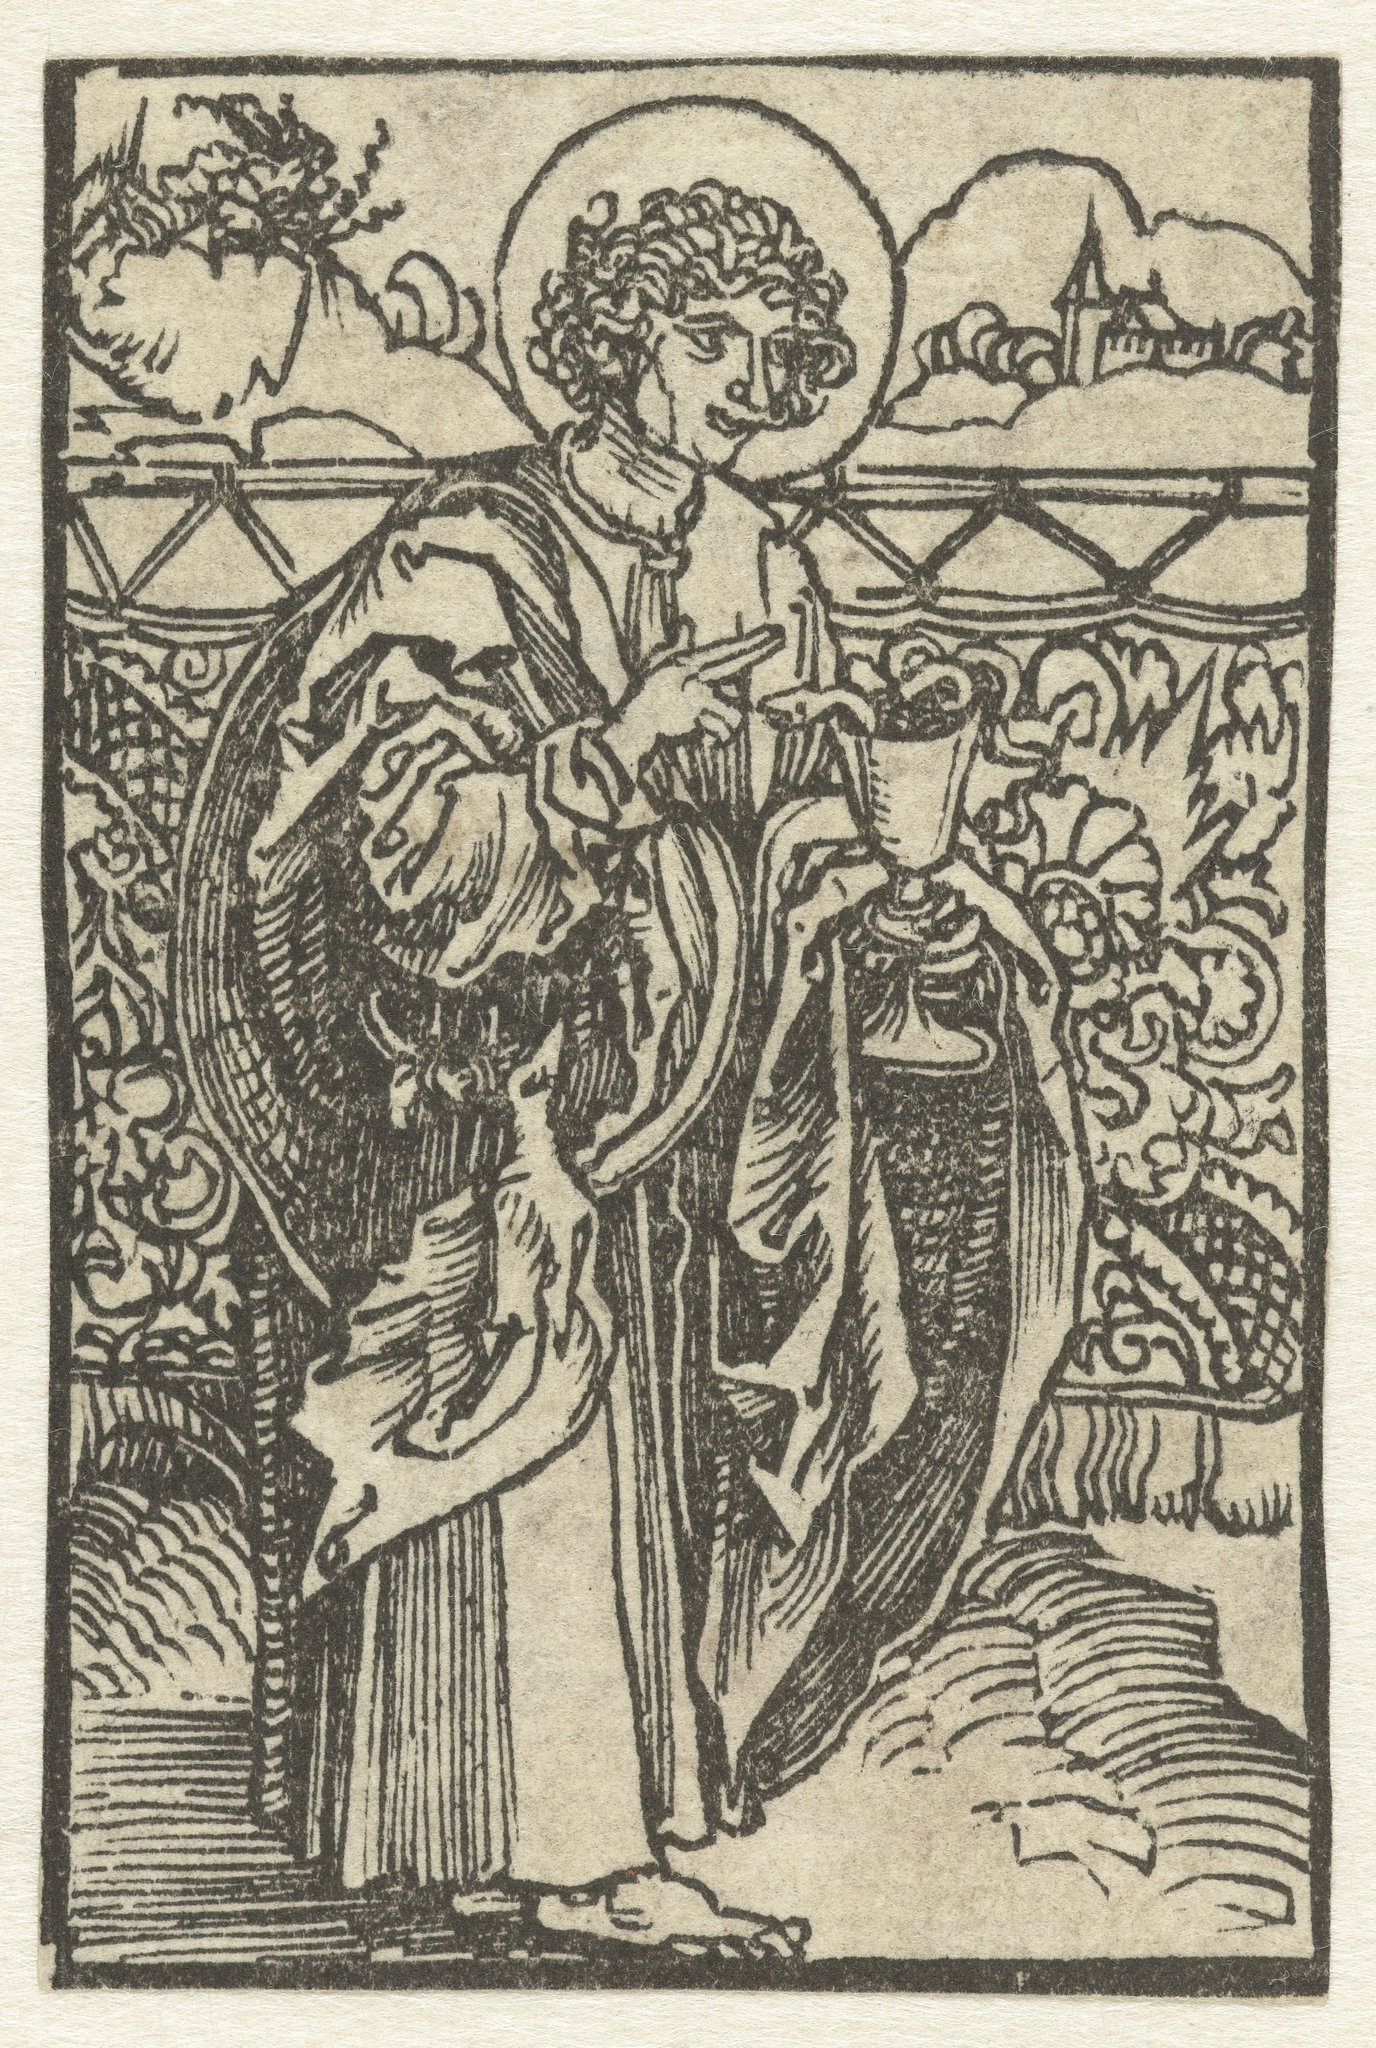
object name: book illustration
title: Apostel Johannes de Evangelist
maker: albrecht dürer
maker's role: draughtsman, painter, print maker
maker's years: 1471-1528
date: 1503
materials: paper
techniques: woodcut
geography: nuremberg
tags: the apostle john the evangelist; possible attributes: book, cauldron, chalice with snake, eagle, palm, scroll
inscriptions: collector's mark: Lugt 240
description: Illustratie voor: Salus anim[a]e, Neurenberg: Hieronymus Höltzel, 1503. Klinkert, C.